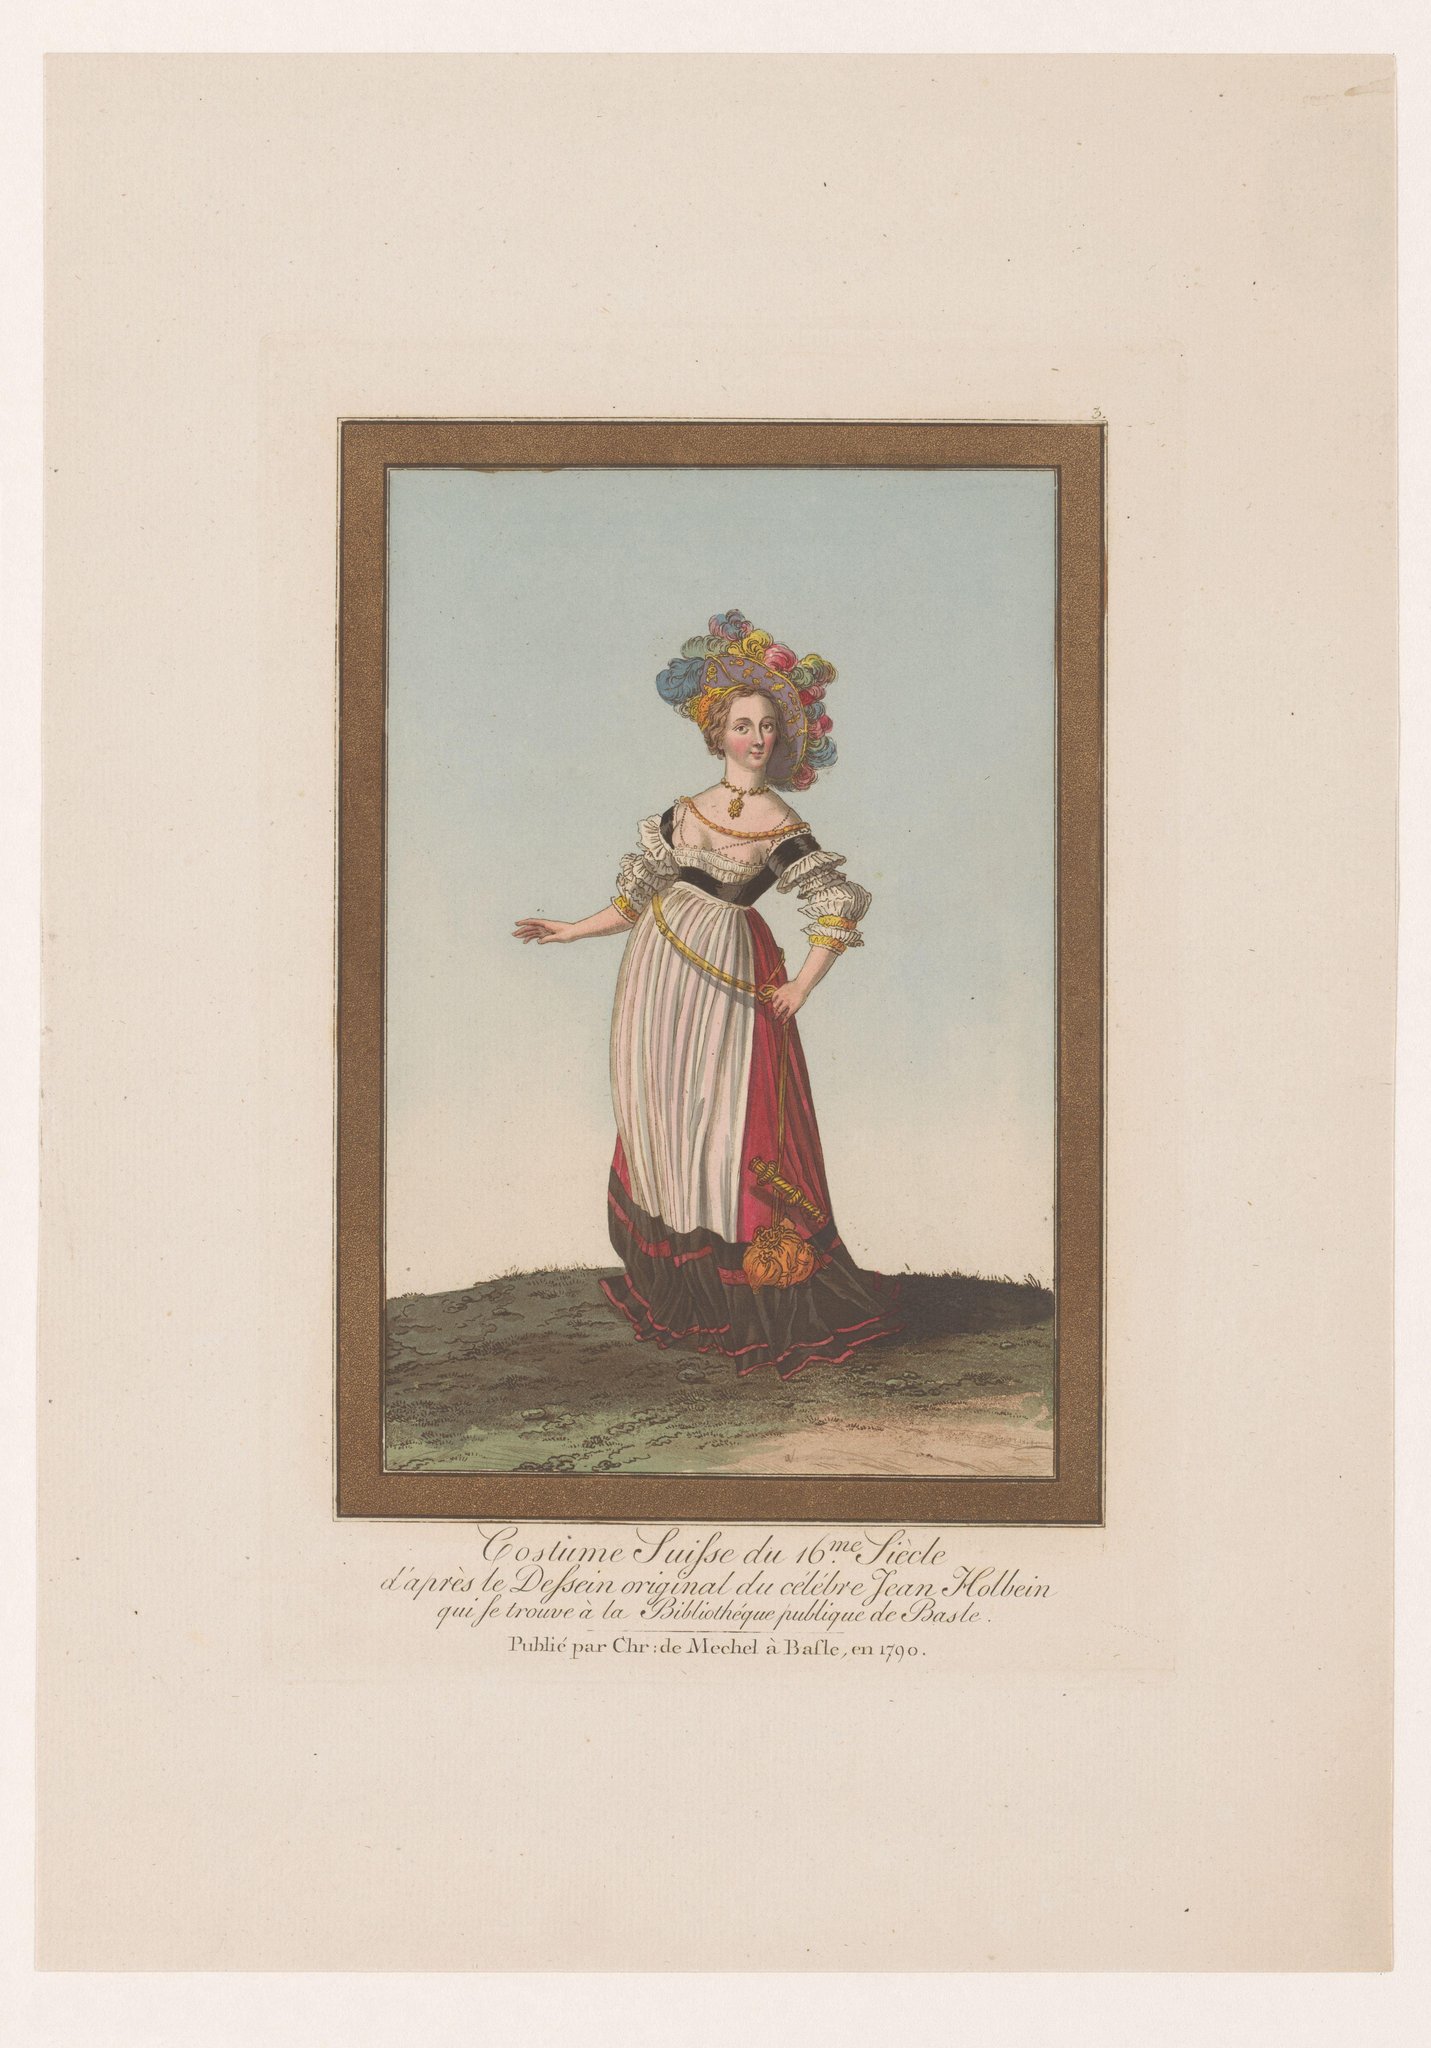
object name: print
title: Vrouw met buidel en besteketui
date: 1790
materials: paper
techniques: aquatint, etching, hand coloring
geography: basel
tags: purse, money-bag, dress, gown: court gown or court dress, clothes, costume, switzerland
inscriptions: collector's mark: Lugt 2228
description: De serie behoort tot de 4-delige publicatie 'Oeuvre de Jean Holbein', Bazel 1780-1795, door Christian von Mechel.